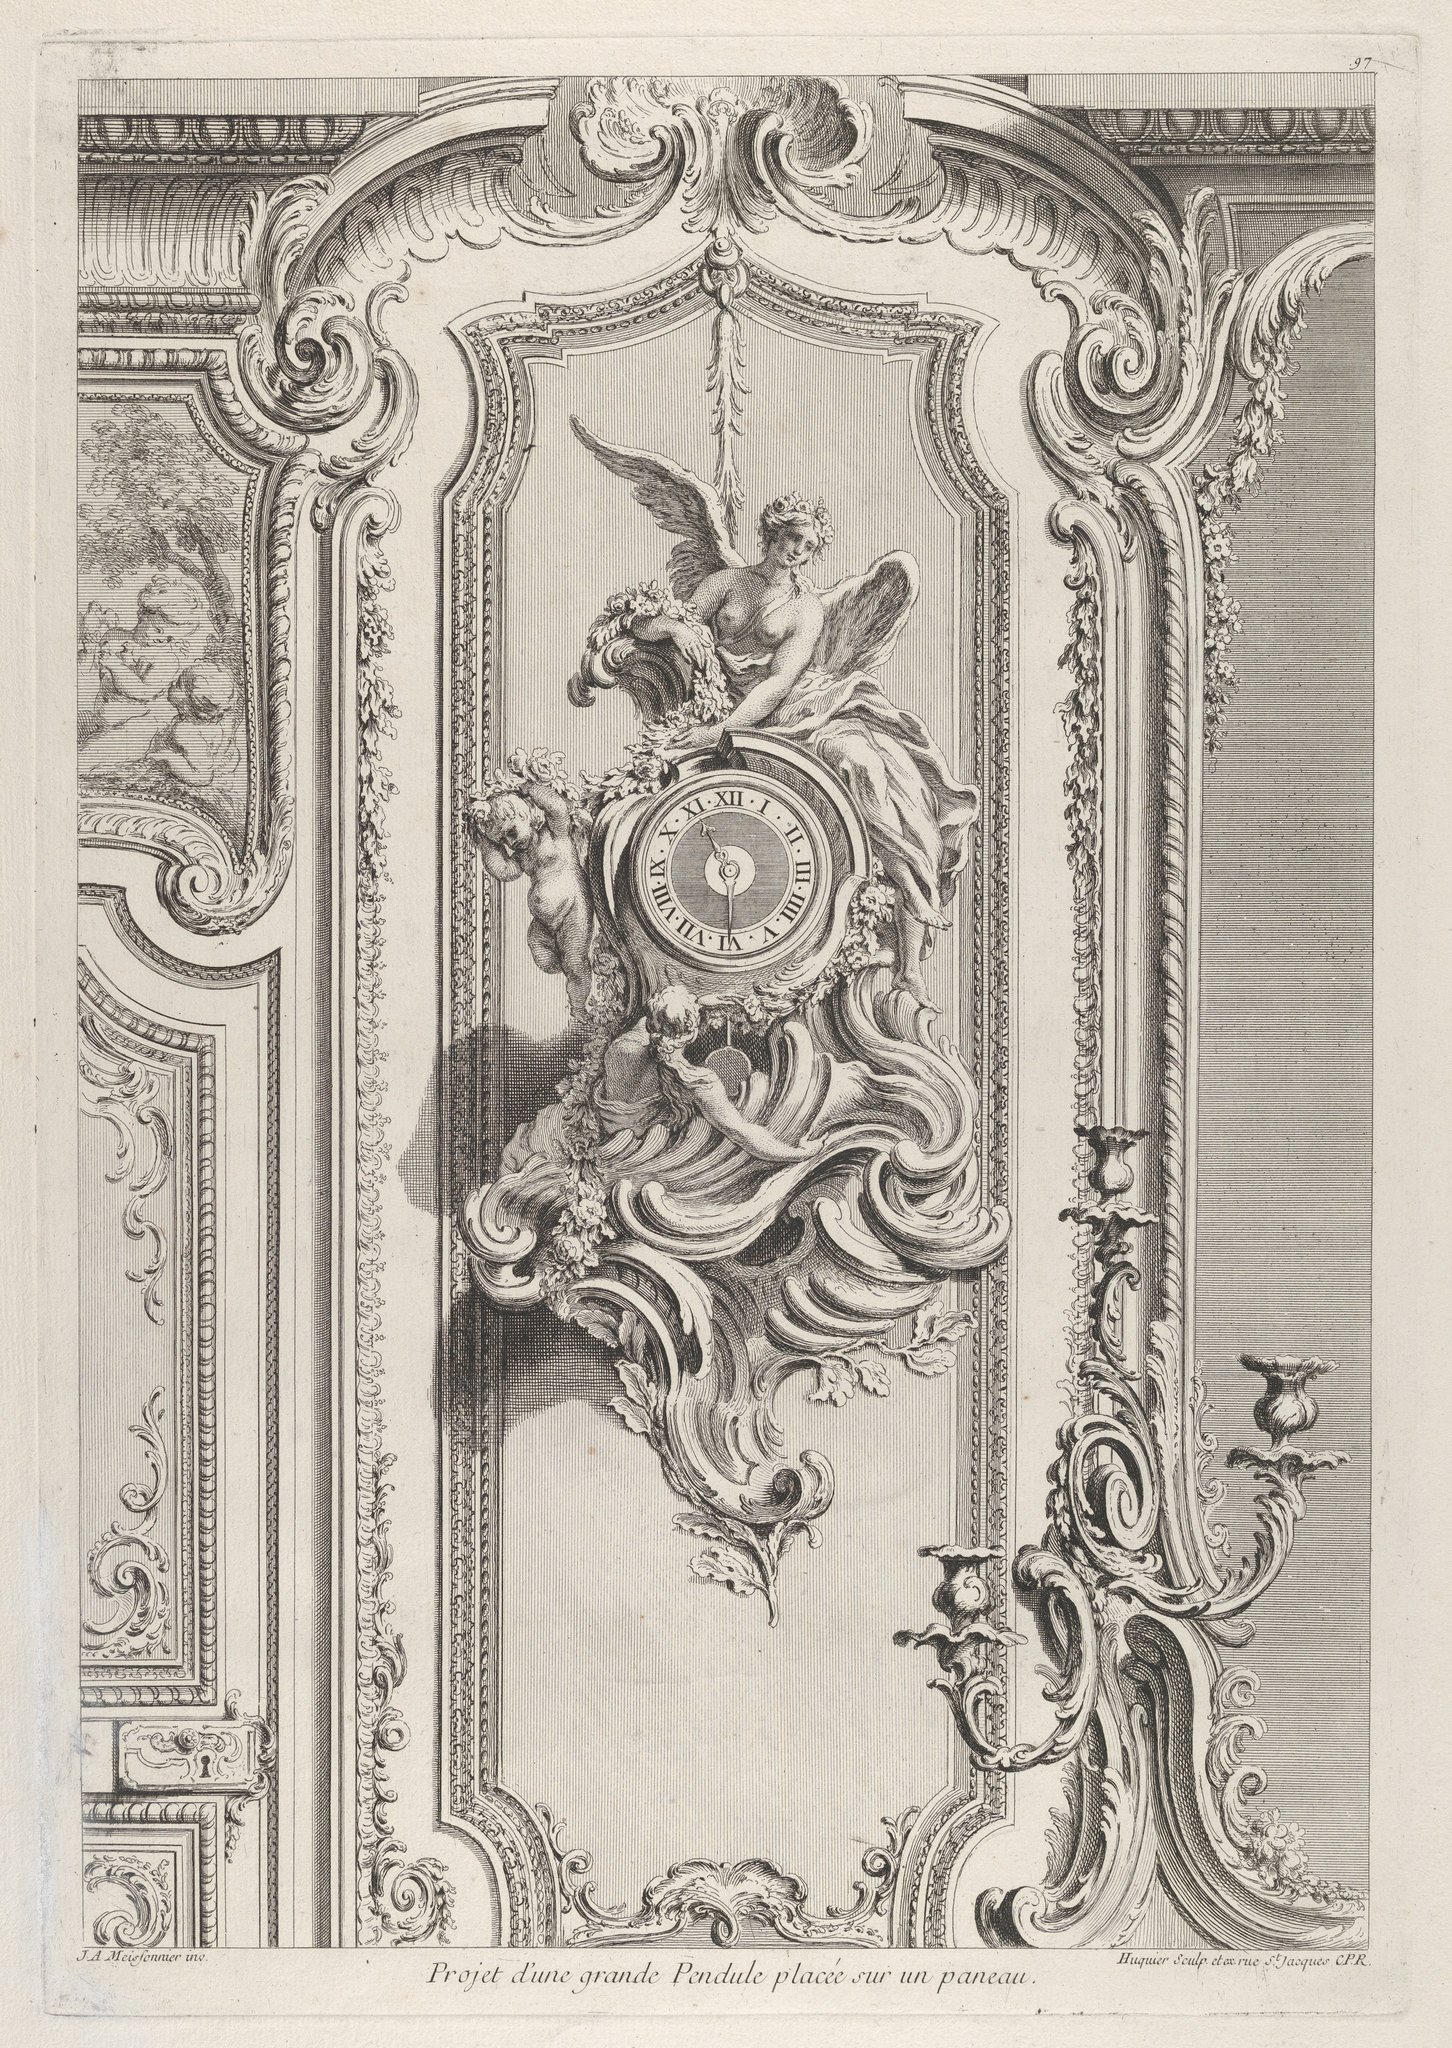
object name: print ornament architecture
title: Projet d'une grande Pendule, from 'Oeuvre de Juste Aurele Meissonnier'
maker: juste aurèle meissonnier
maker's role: artist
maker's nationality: french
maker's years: 1695-1750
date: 1742-1748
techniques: engraving, etching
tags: ornament,clocks